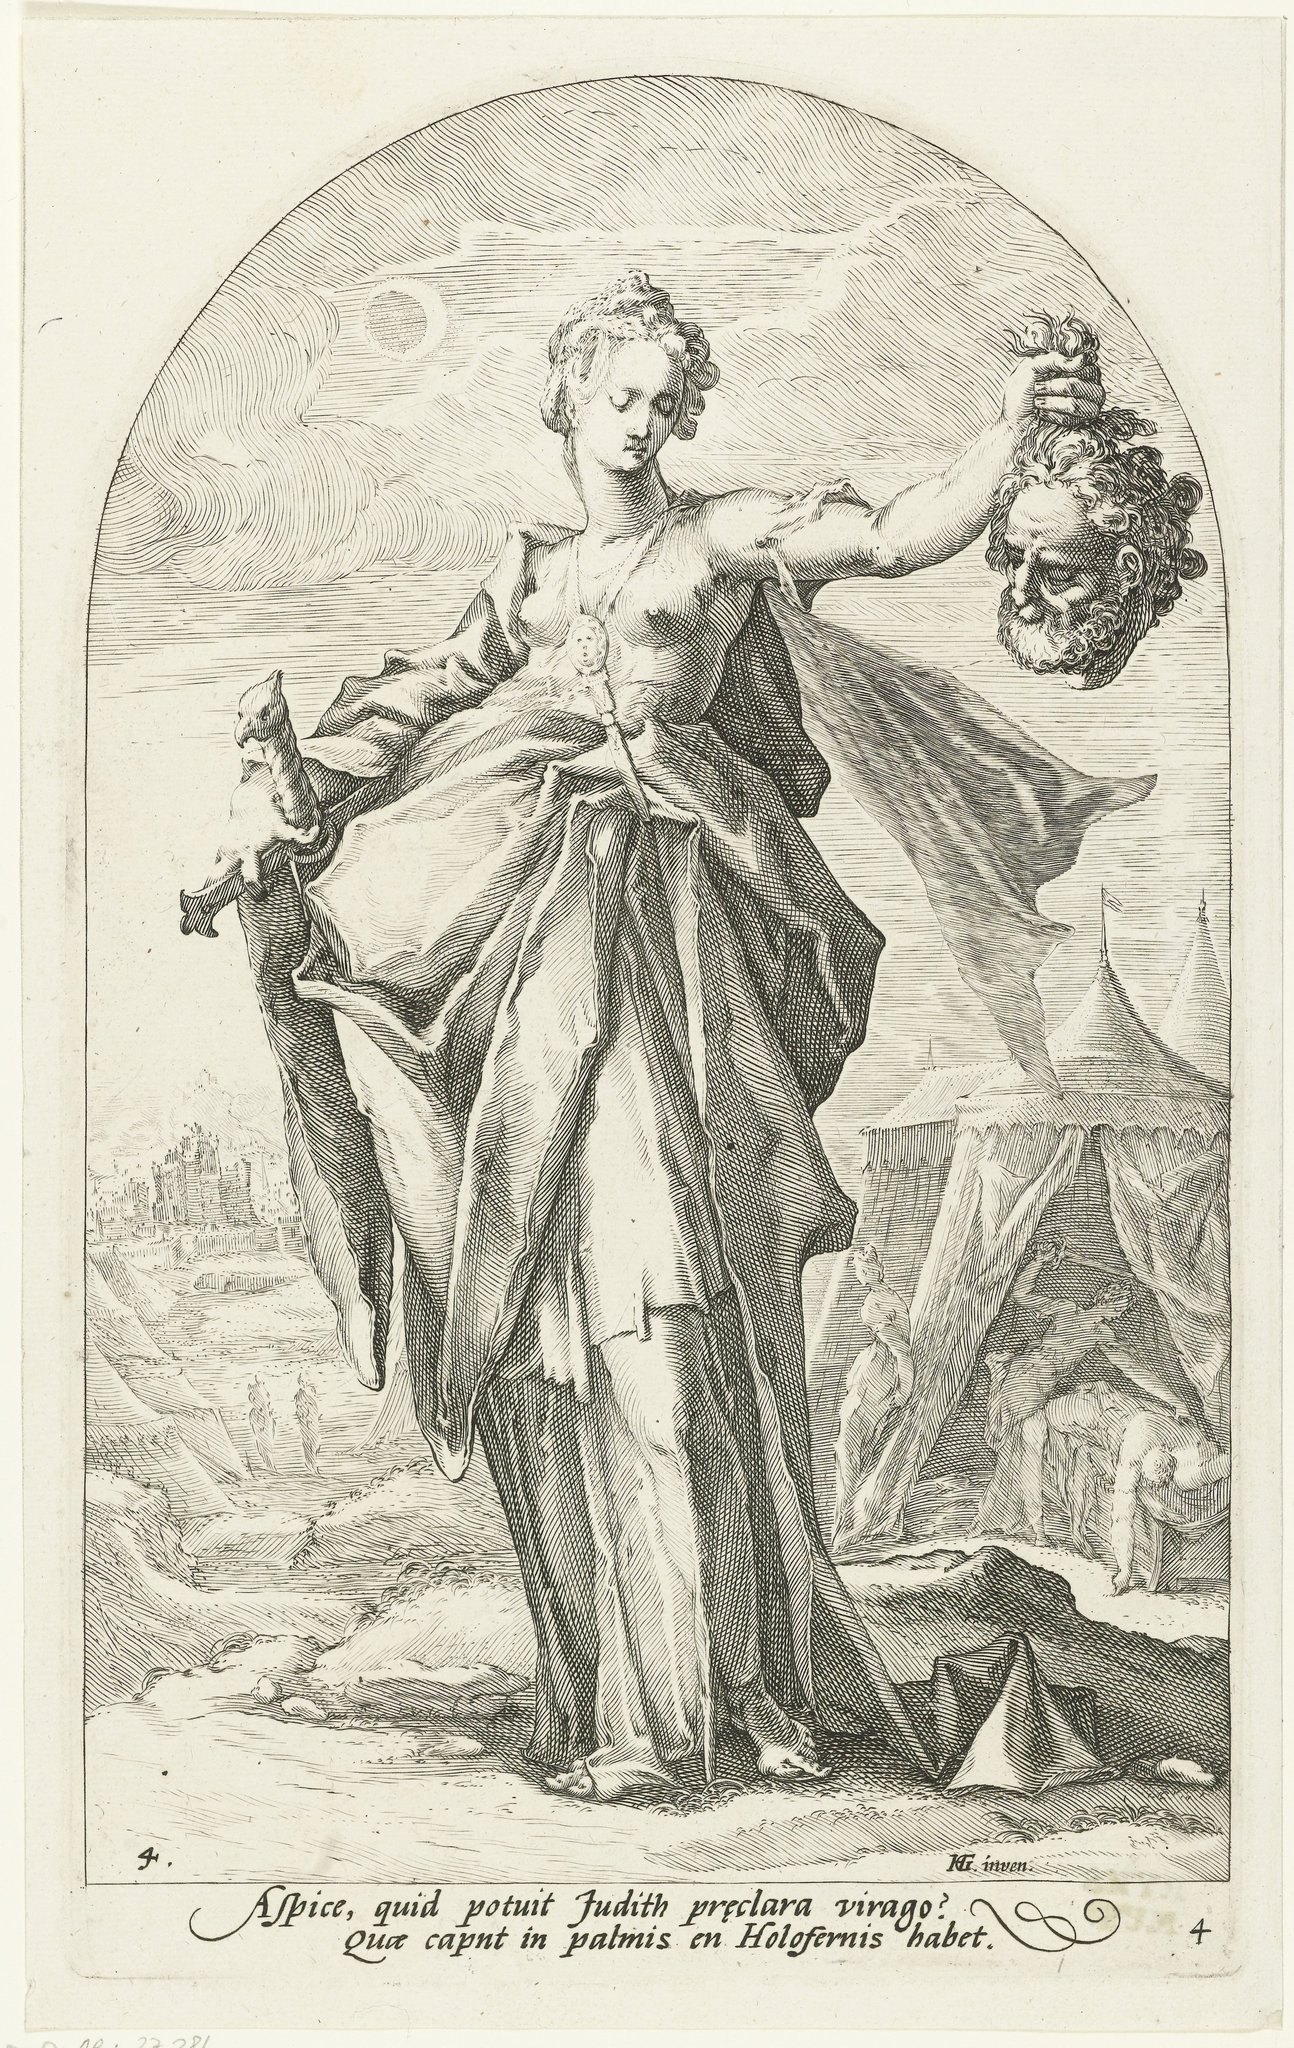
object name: print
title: Helden en heldinnen van het Oude Testament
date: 1585-1589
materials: paper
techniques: engraving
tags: judith with holofernes' head and the sword, holofernes beheaded by judith with his own sword; the maidservant may be keeping watch, female persons from the old testament (with name) (not in biblical context), judith (one of the nine worthiest women)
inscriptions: collector's mark: Lugt 2165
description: Judit met het hoofd van Holofernes in de ene, het zwaard in de andere hand. Op de achtergrond de scène waarin zij de legeraanvoerder in zijn tent het hoofd afhakt, terwijl haar dienstmaagd op wacht staat.